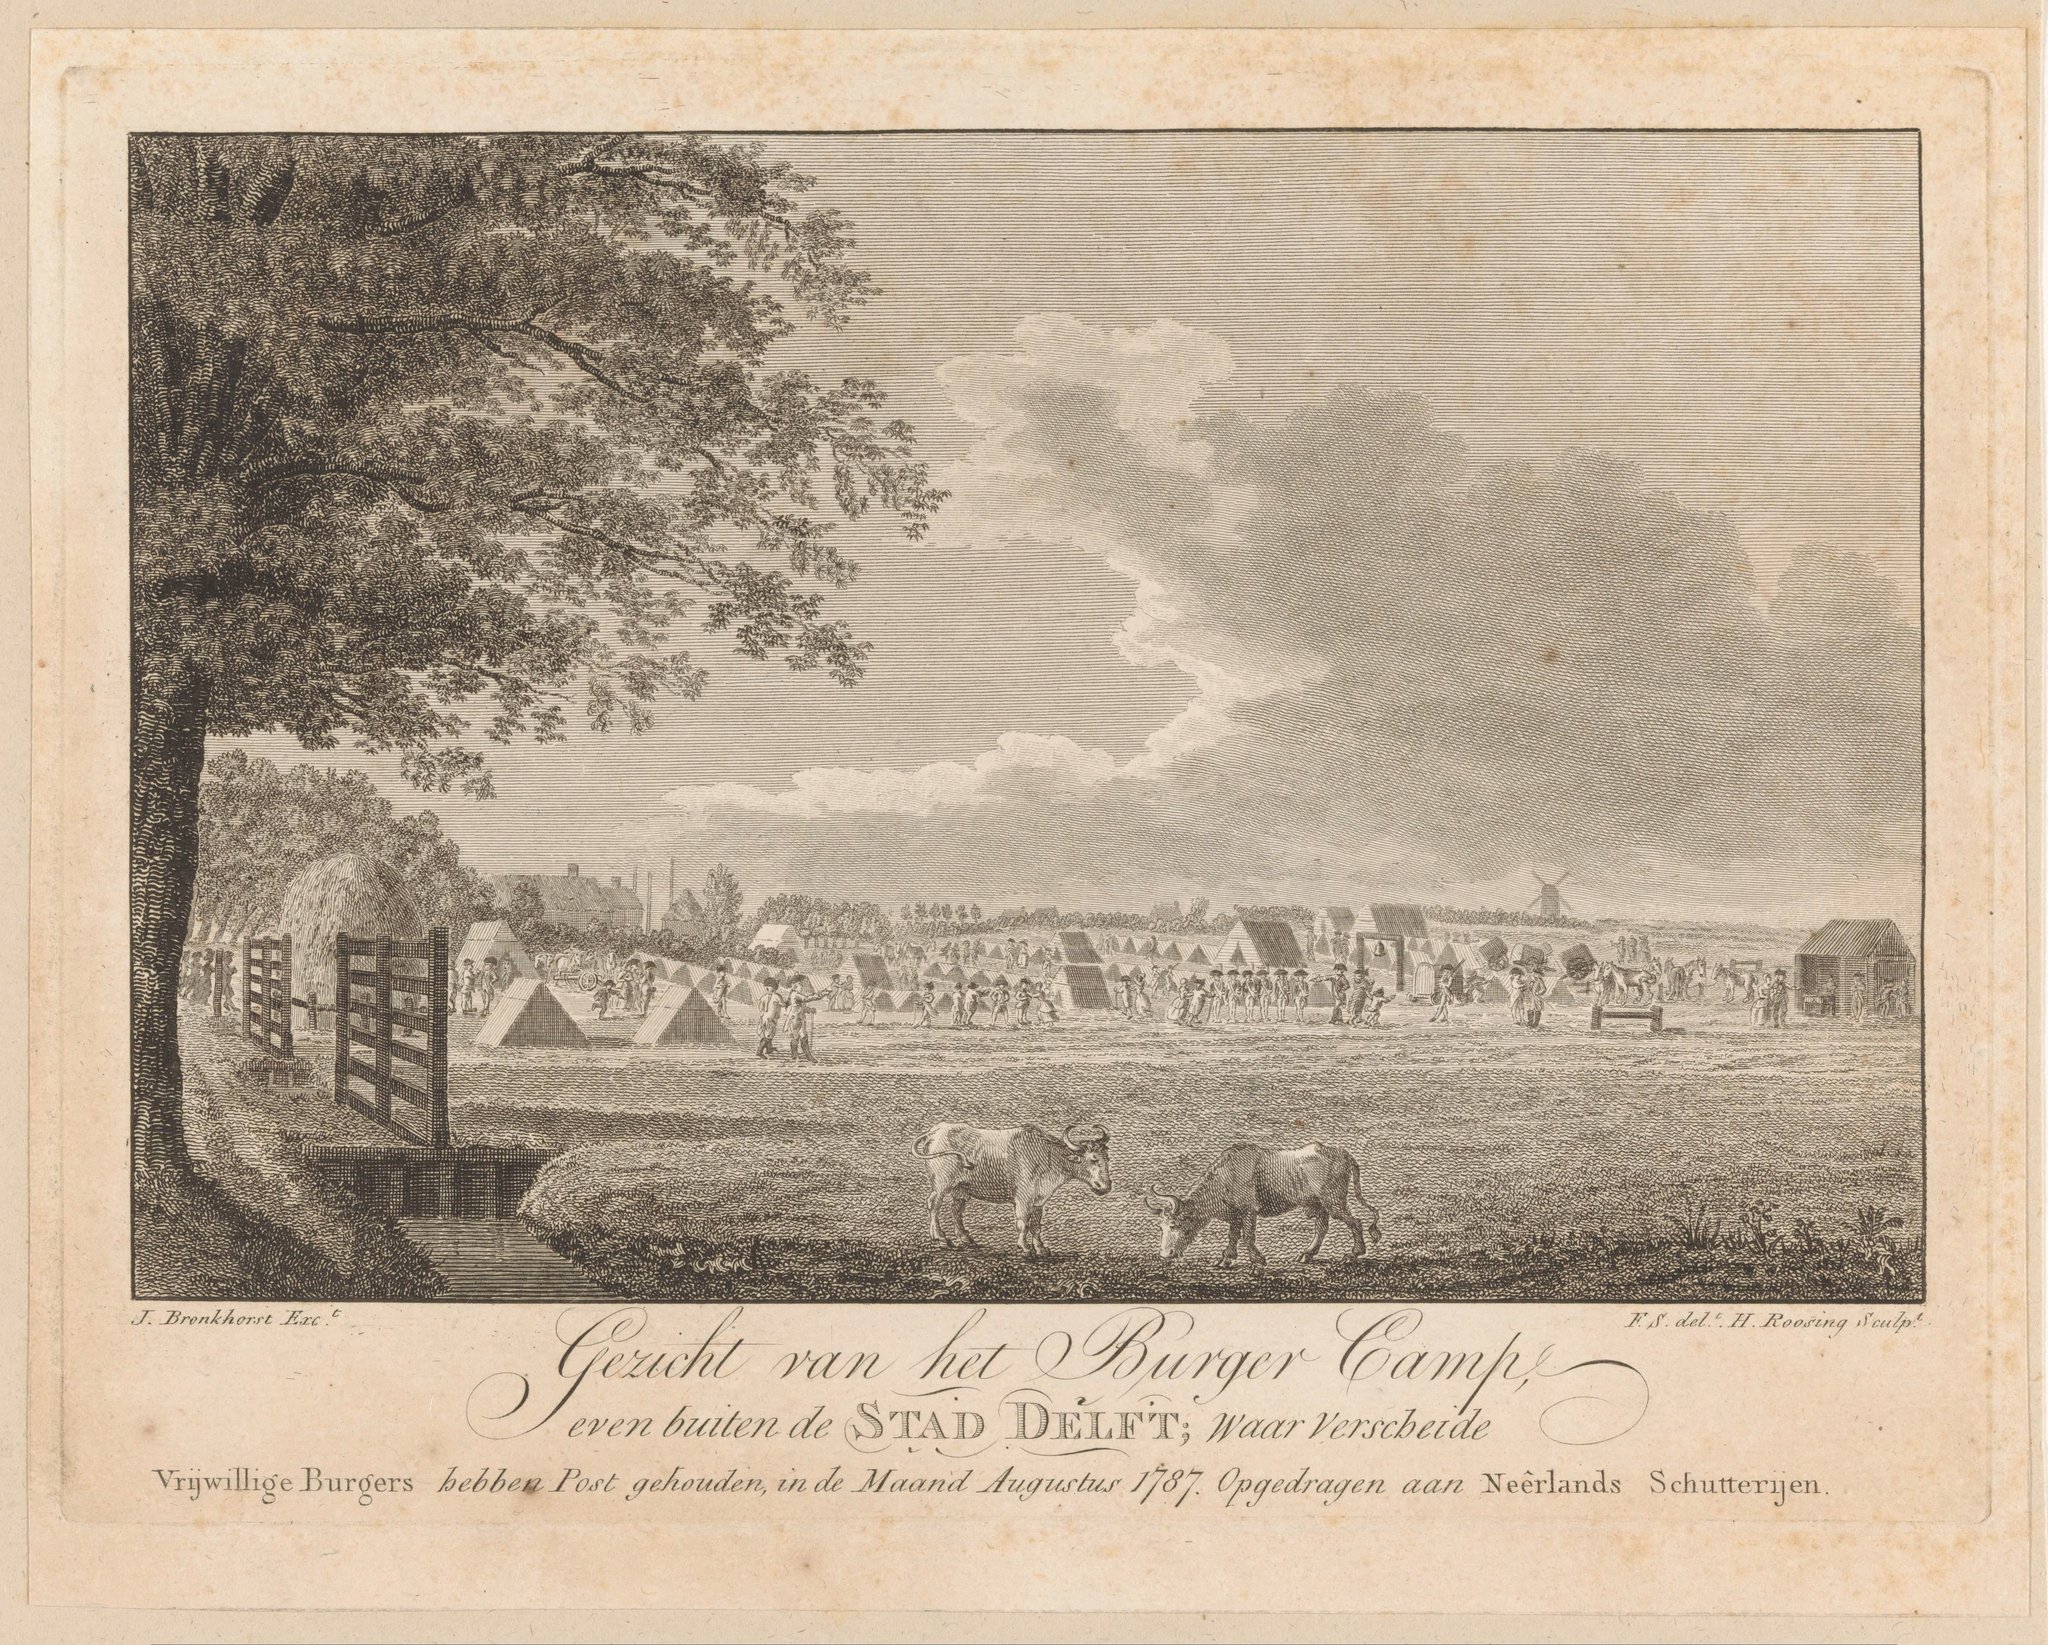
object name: print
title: Kampement te Delft, 1787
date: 1787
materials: paper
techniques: engraving, etching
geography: rotterdam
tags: (military) camp with tents (+ citizen soldiery, civil guard, citizen militia), delft, patriots (1780-1795)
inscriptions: collector's mark: Lugt 2228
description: Gezicht op het kampement van het Vliegend Legertje opgezet in een weiland buiten Delft met de tenten van de vrijkorpsen uit verschillende plaatsen, augustus 1787. Opgedragen aan 'Neêrlands Schutterijen'.